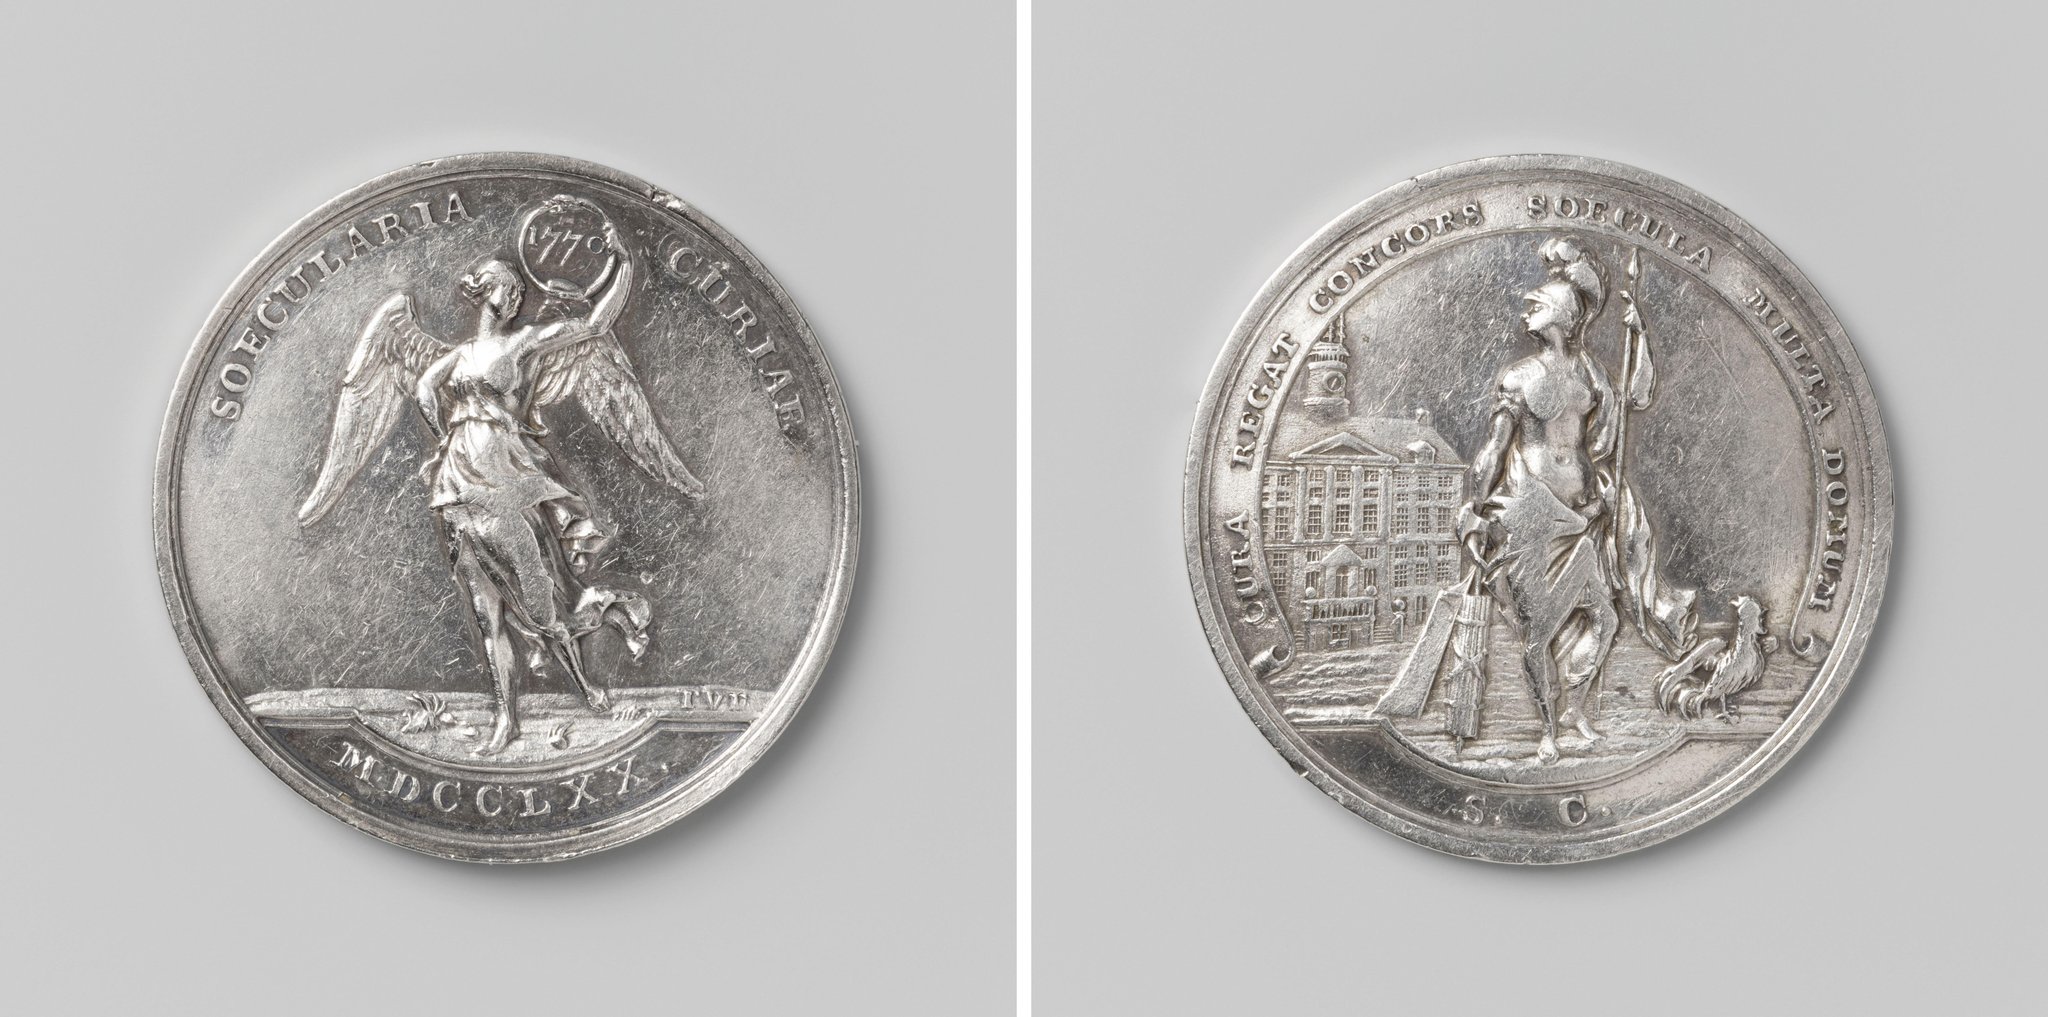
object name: council medal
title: 's-Hertogenbosch, vroedschapspenning op het eeuwfeest van de herbouwing van het stadhuis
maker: theodorus victor van berckel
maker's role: mintmaster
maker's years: 1739-1808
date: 1770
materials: silver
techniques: striking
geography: den bosch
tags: den bosch